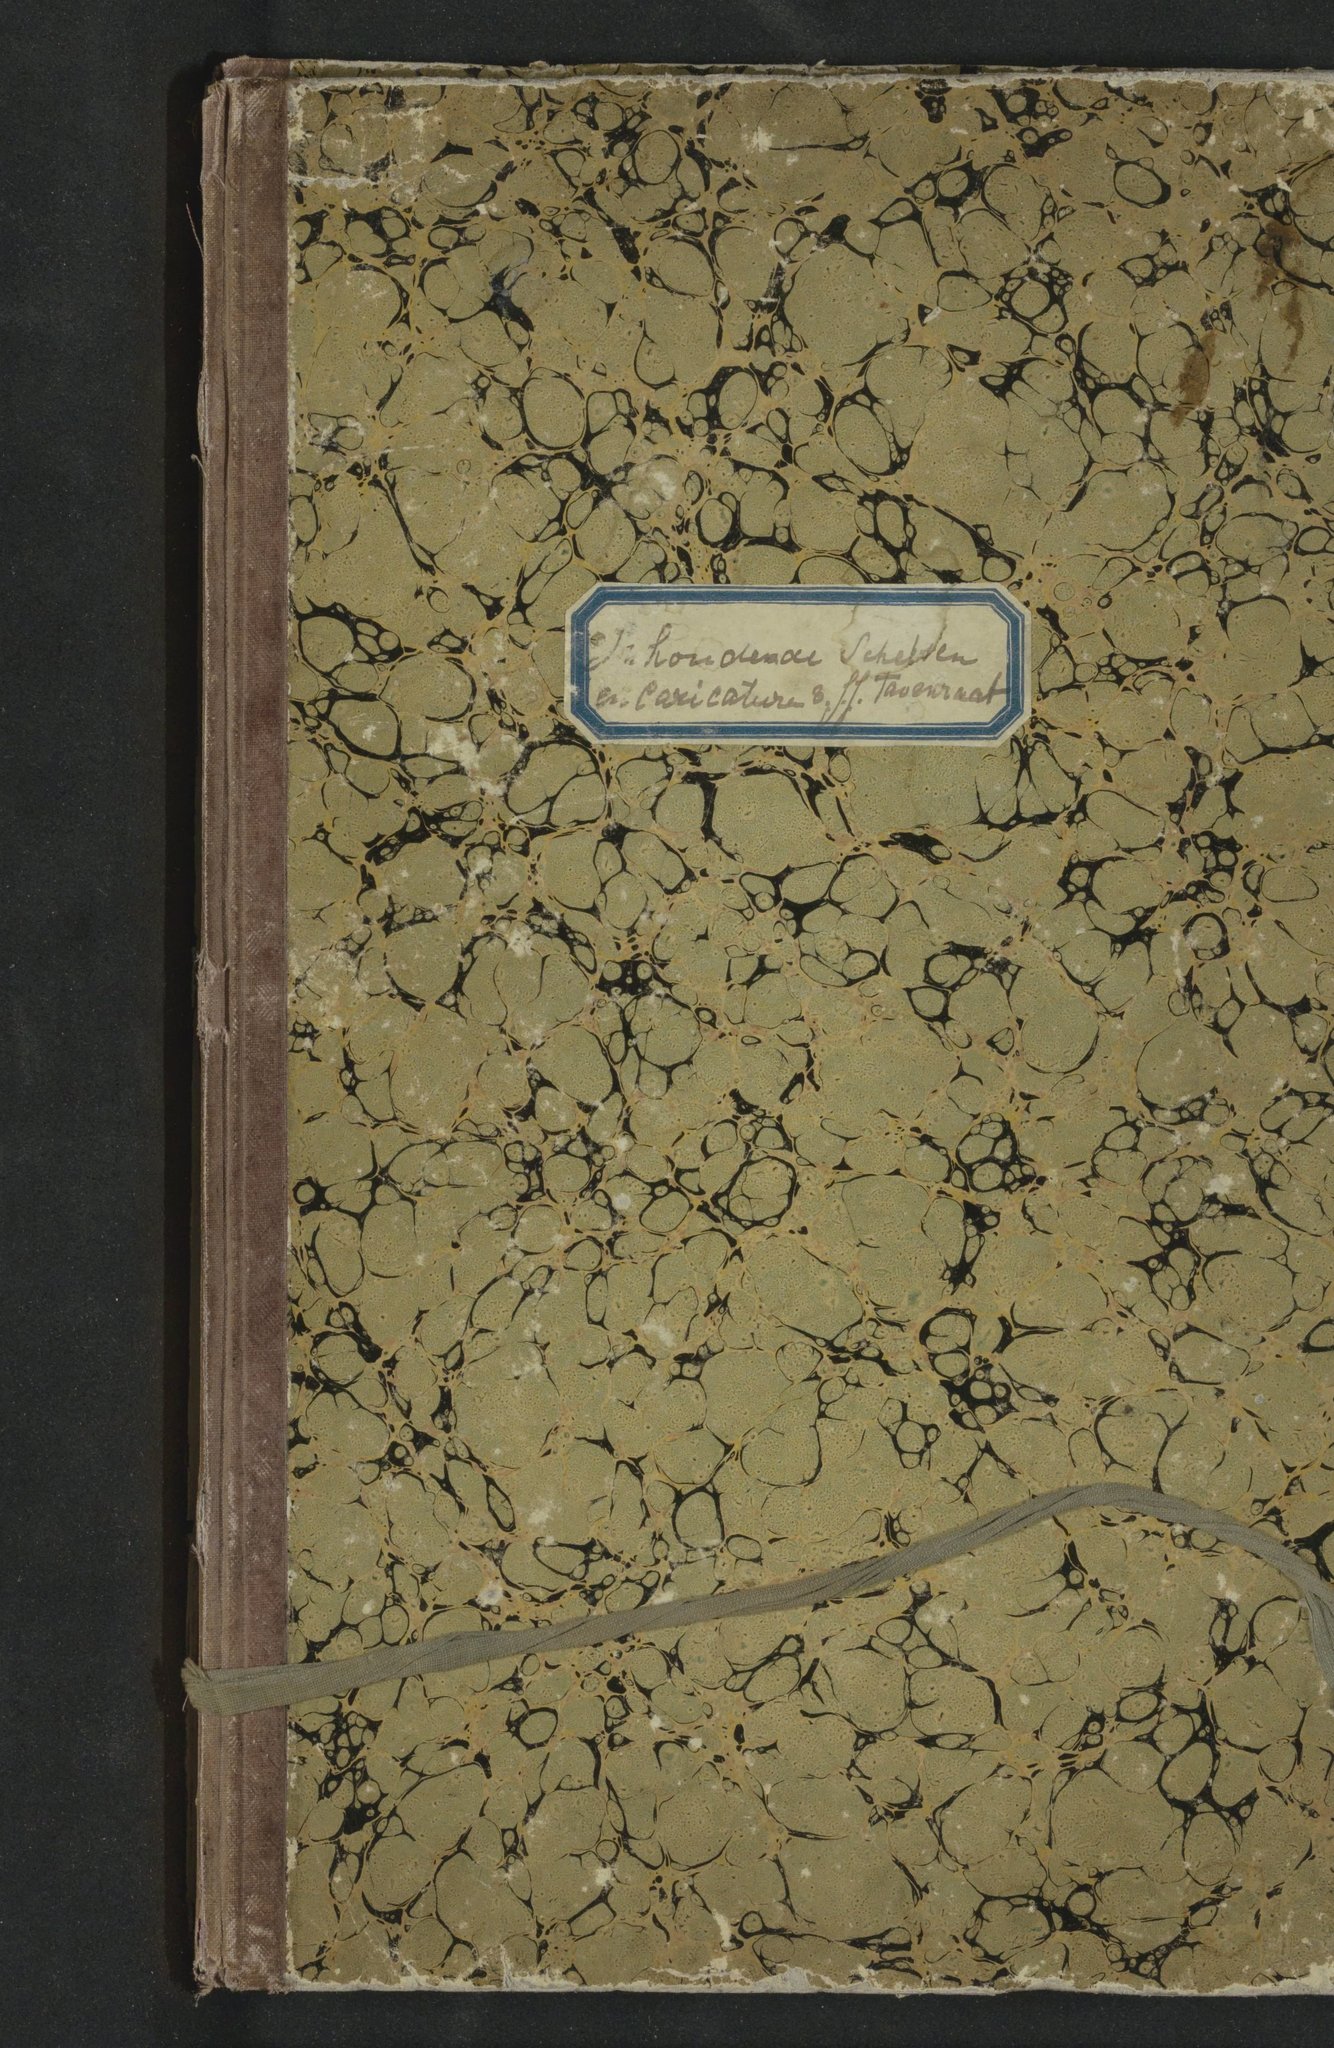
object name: album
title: Schetsboek met 59 bladen met studies van Johannes Antonius Canta en ingeplakte schetsen van Johannes Tavenraat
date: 1826-1888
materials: cardboard, ink, linen, paper, pencil, watercolor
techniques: brush, etching, pen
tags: animals, firearms, (military) uniforms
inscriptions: signature: ‘J.A. Canta.’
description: Schets- en plakboek van Johannes Antonius Canta. Met de leesrichting mee enkele schetsen van Canta. Vermoedelijk is het schetsboek vervolgens omgekeerd en gebruikt als plakboek om schetsen van Johannes Tavenraat, vaak uitgeknipt uit brieven, in te bewaren. Pagina 1, de verso van bladen 2 t/m 21, bladen 22 t/m 40, de recto van bladen 41 t/m 58 en blad 59 zijn blanco.